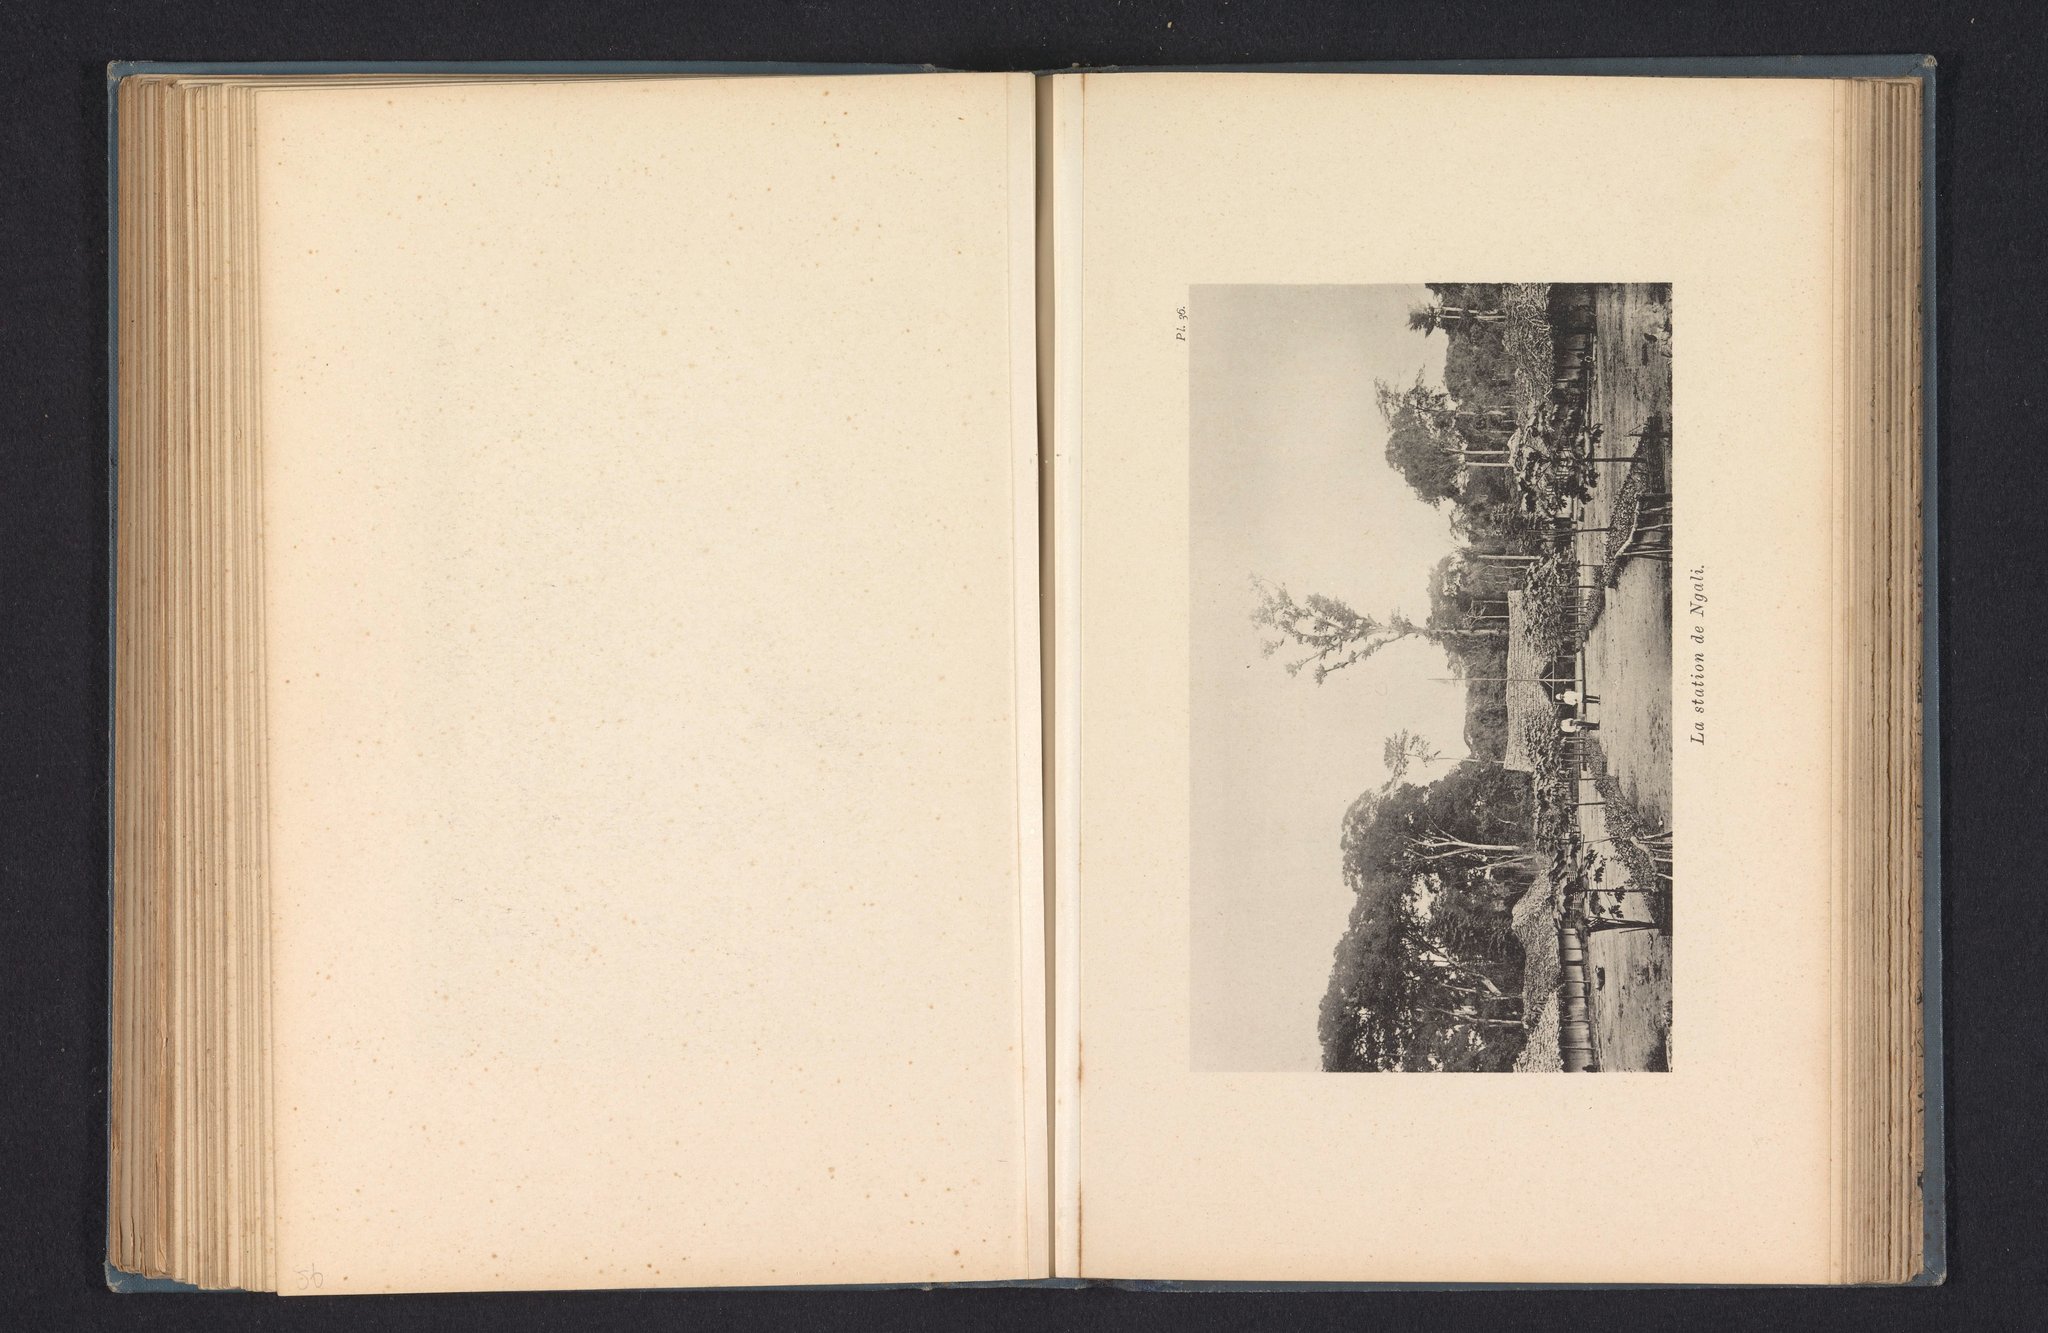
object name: page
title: Exterieur van het stationsgebouw te Ngali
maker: franz thonner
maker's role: botanicus, ontdekkingsreiziger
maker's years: 1863-1928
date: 1896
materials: paper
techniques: photograph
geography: ngali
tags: façade (of house or building), station; shelter (railway, tramway)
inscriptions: number: ‘Pl. 36.’